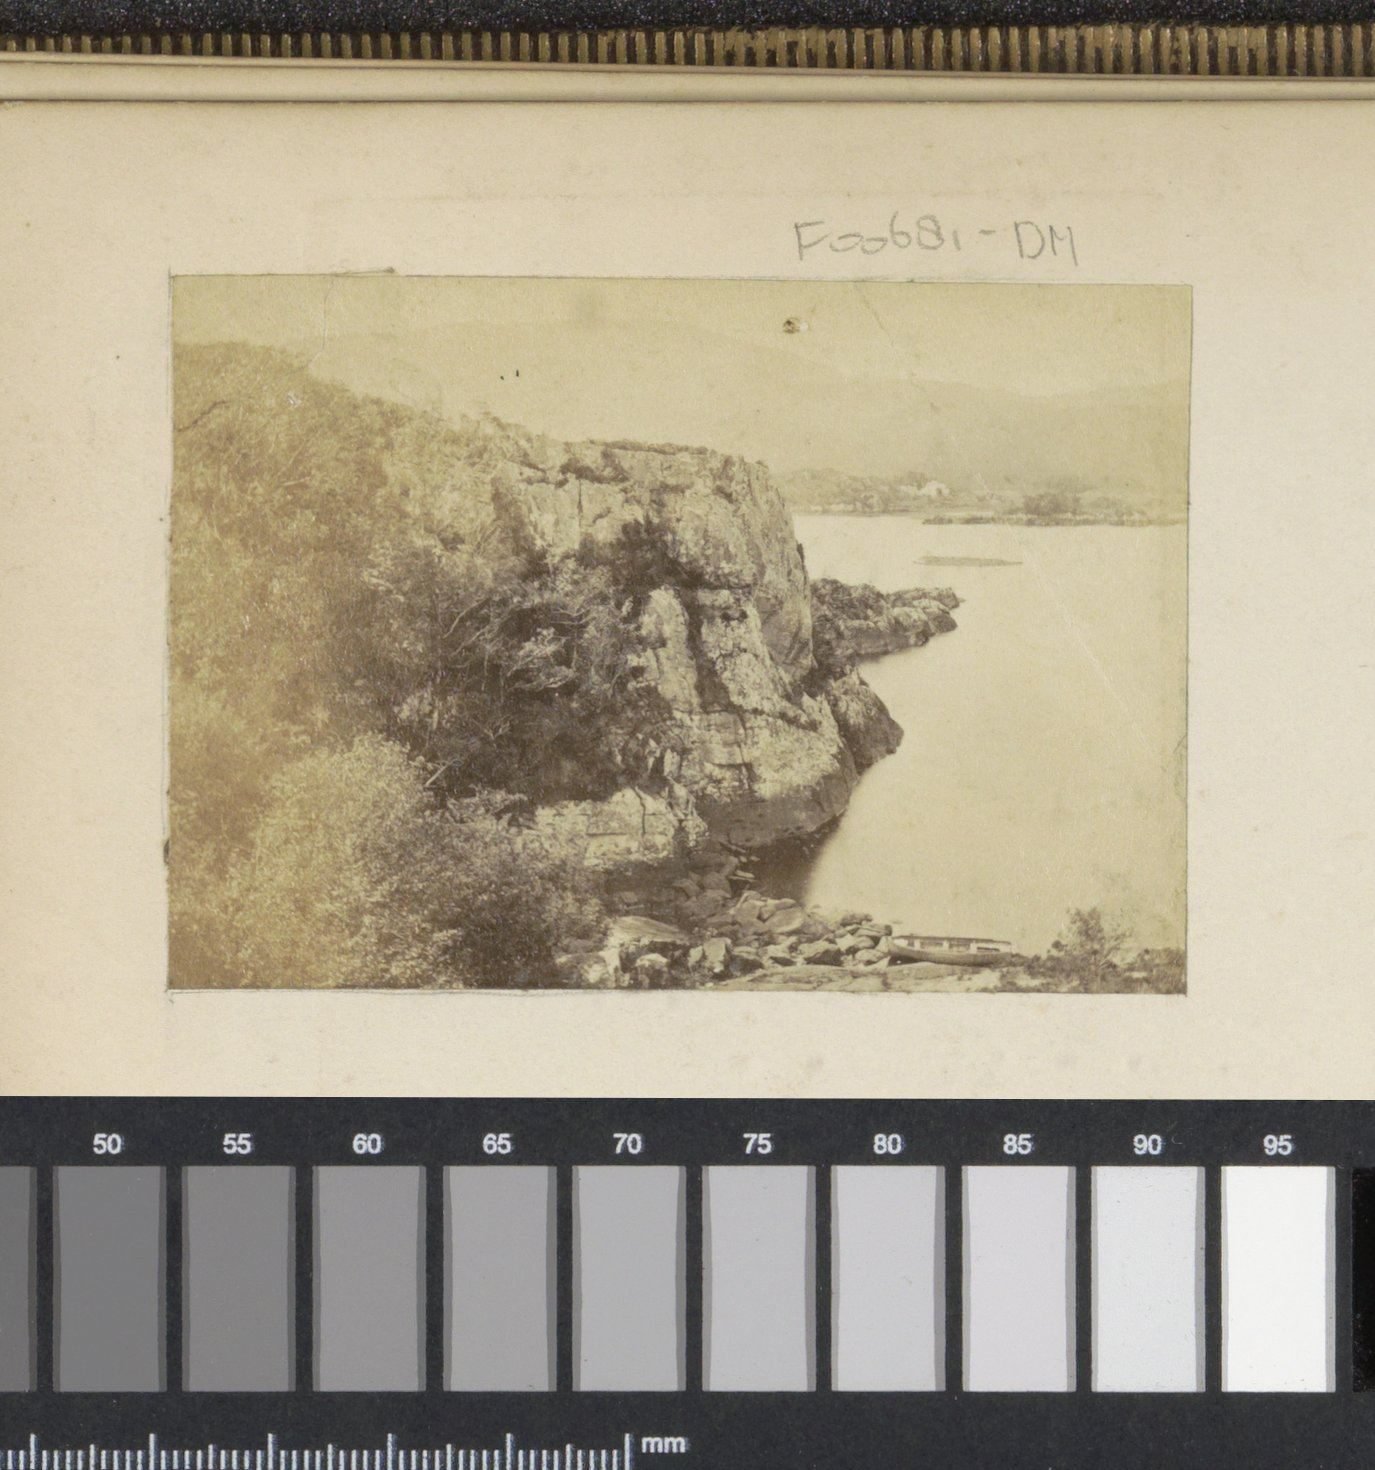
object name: photograph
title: Gezicht op een rotskust bij een meer of zee, vermoedelijk in Engeland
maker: Anonymous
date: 1850-1870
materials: paper, photographic support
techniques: albumen print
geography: england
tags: coastal cliff or crag, england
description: Onderdeel van Album met foto's van bezienswaardigheden en landschappen in Engeland en van kunst.